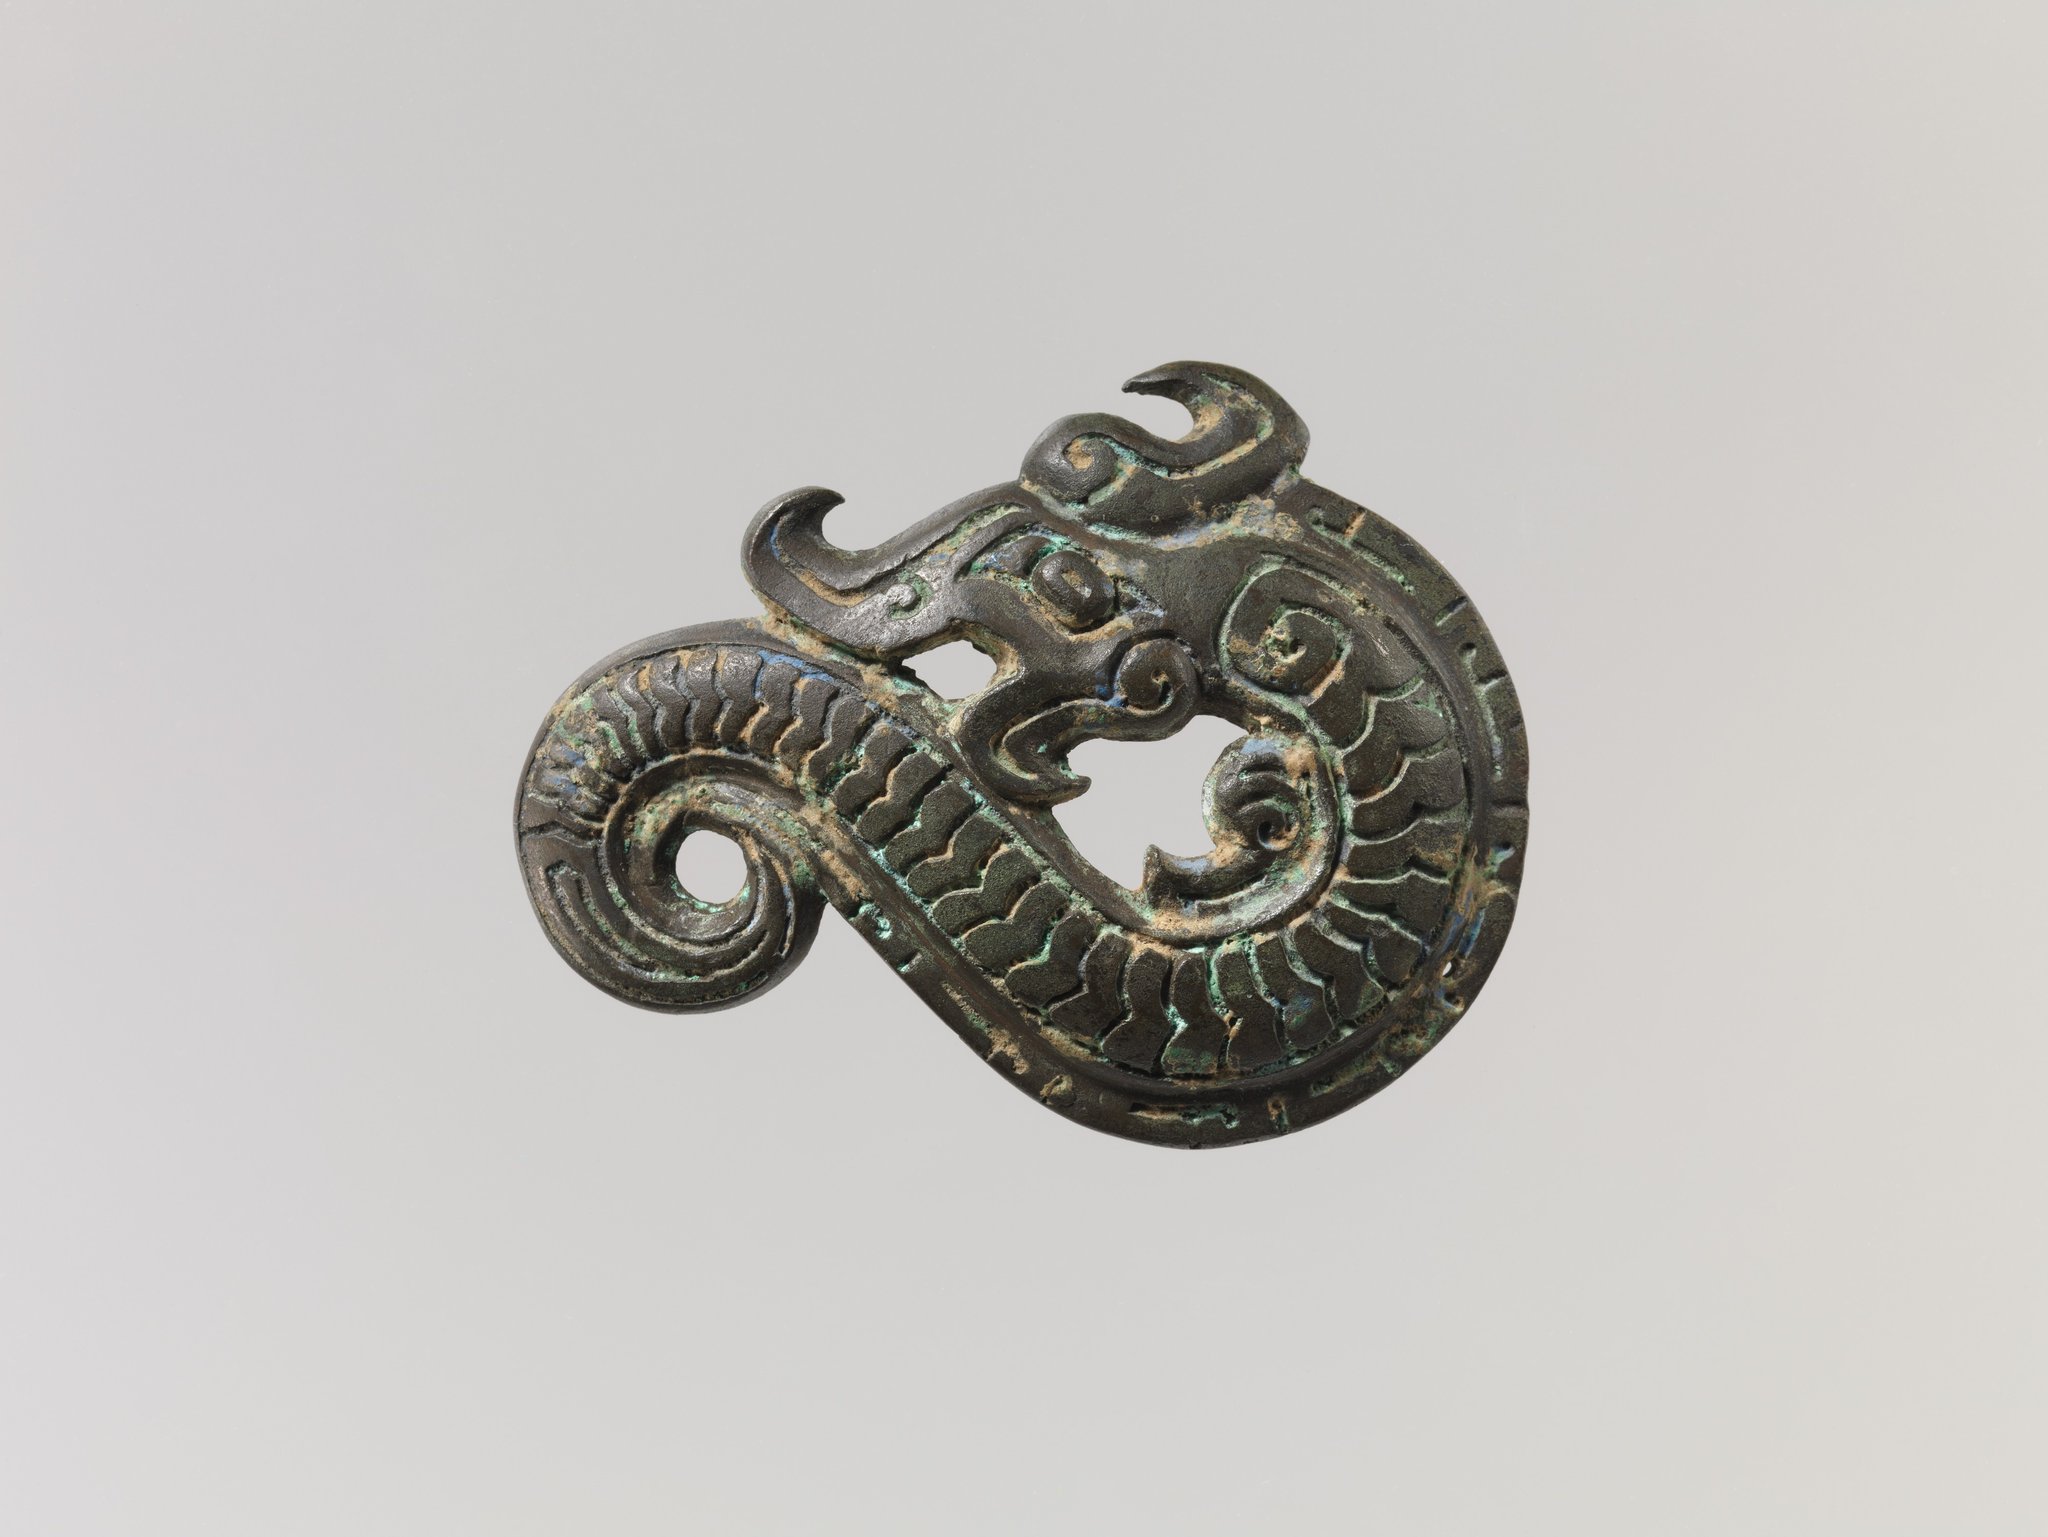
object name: appliqué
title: Appliqué in the Form of a Dragon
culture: chinese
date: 1300-1001 BCE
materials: bronze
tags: dragons